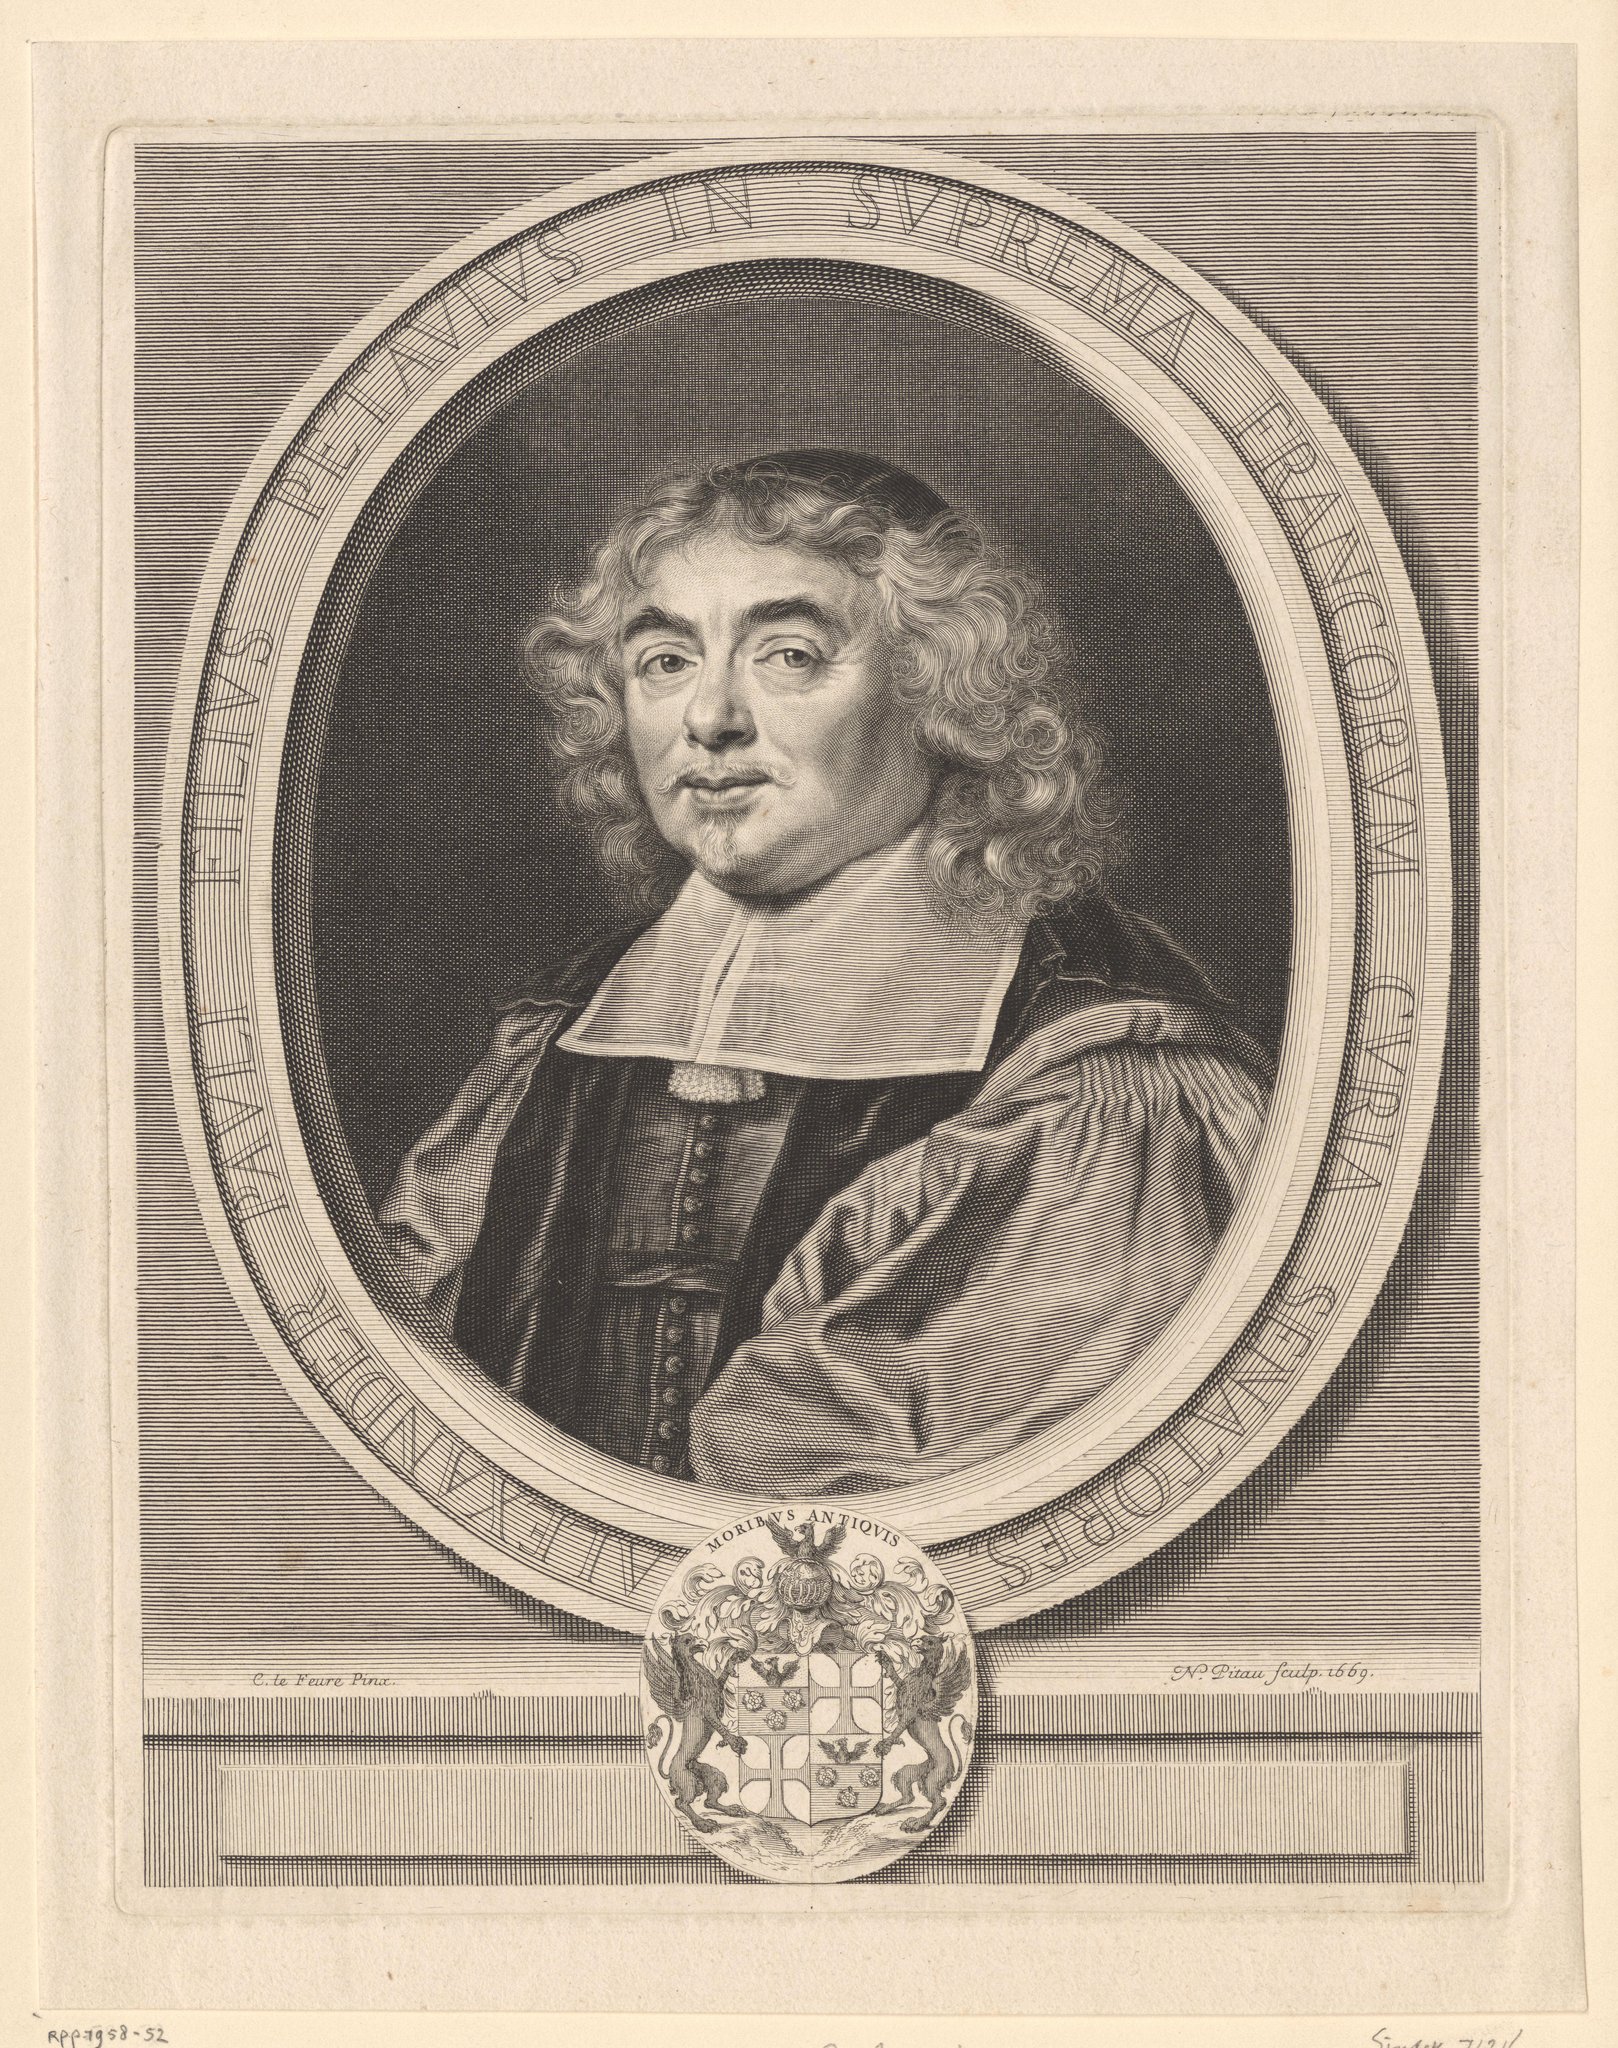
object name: print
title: Portret van Alexandre Petau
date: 1669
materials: paper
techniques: engraving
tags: adult man, historical persons, armorial bearing, heraldry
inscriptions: mark: Lugt 533b